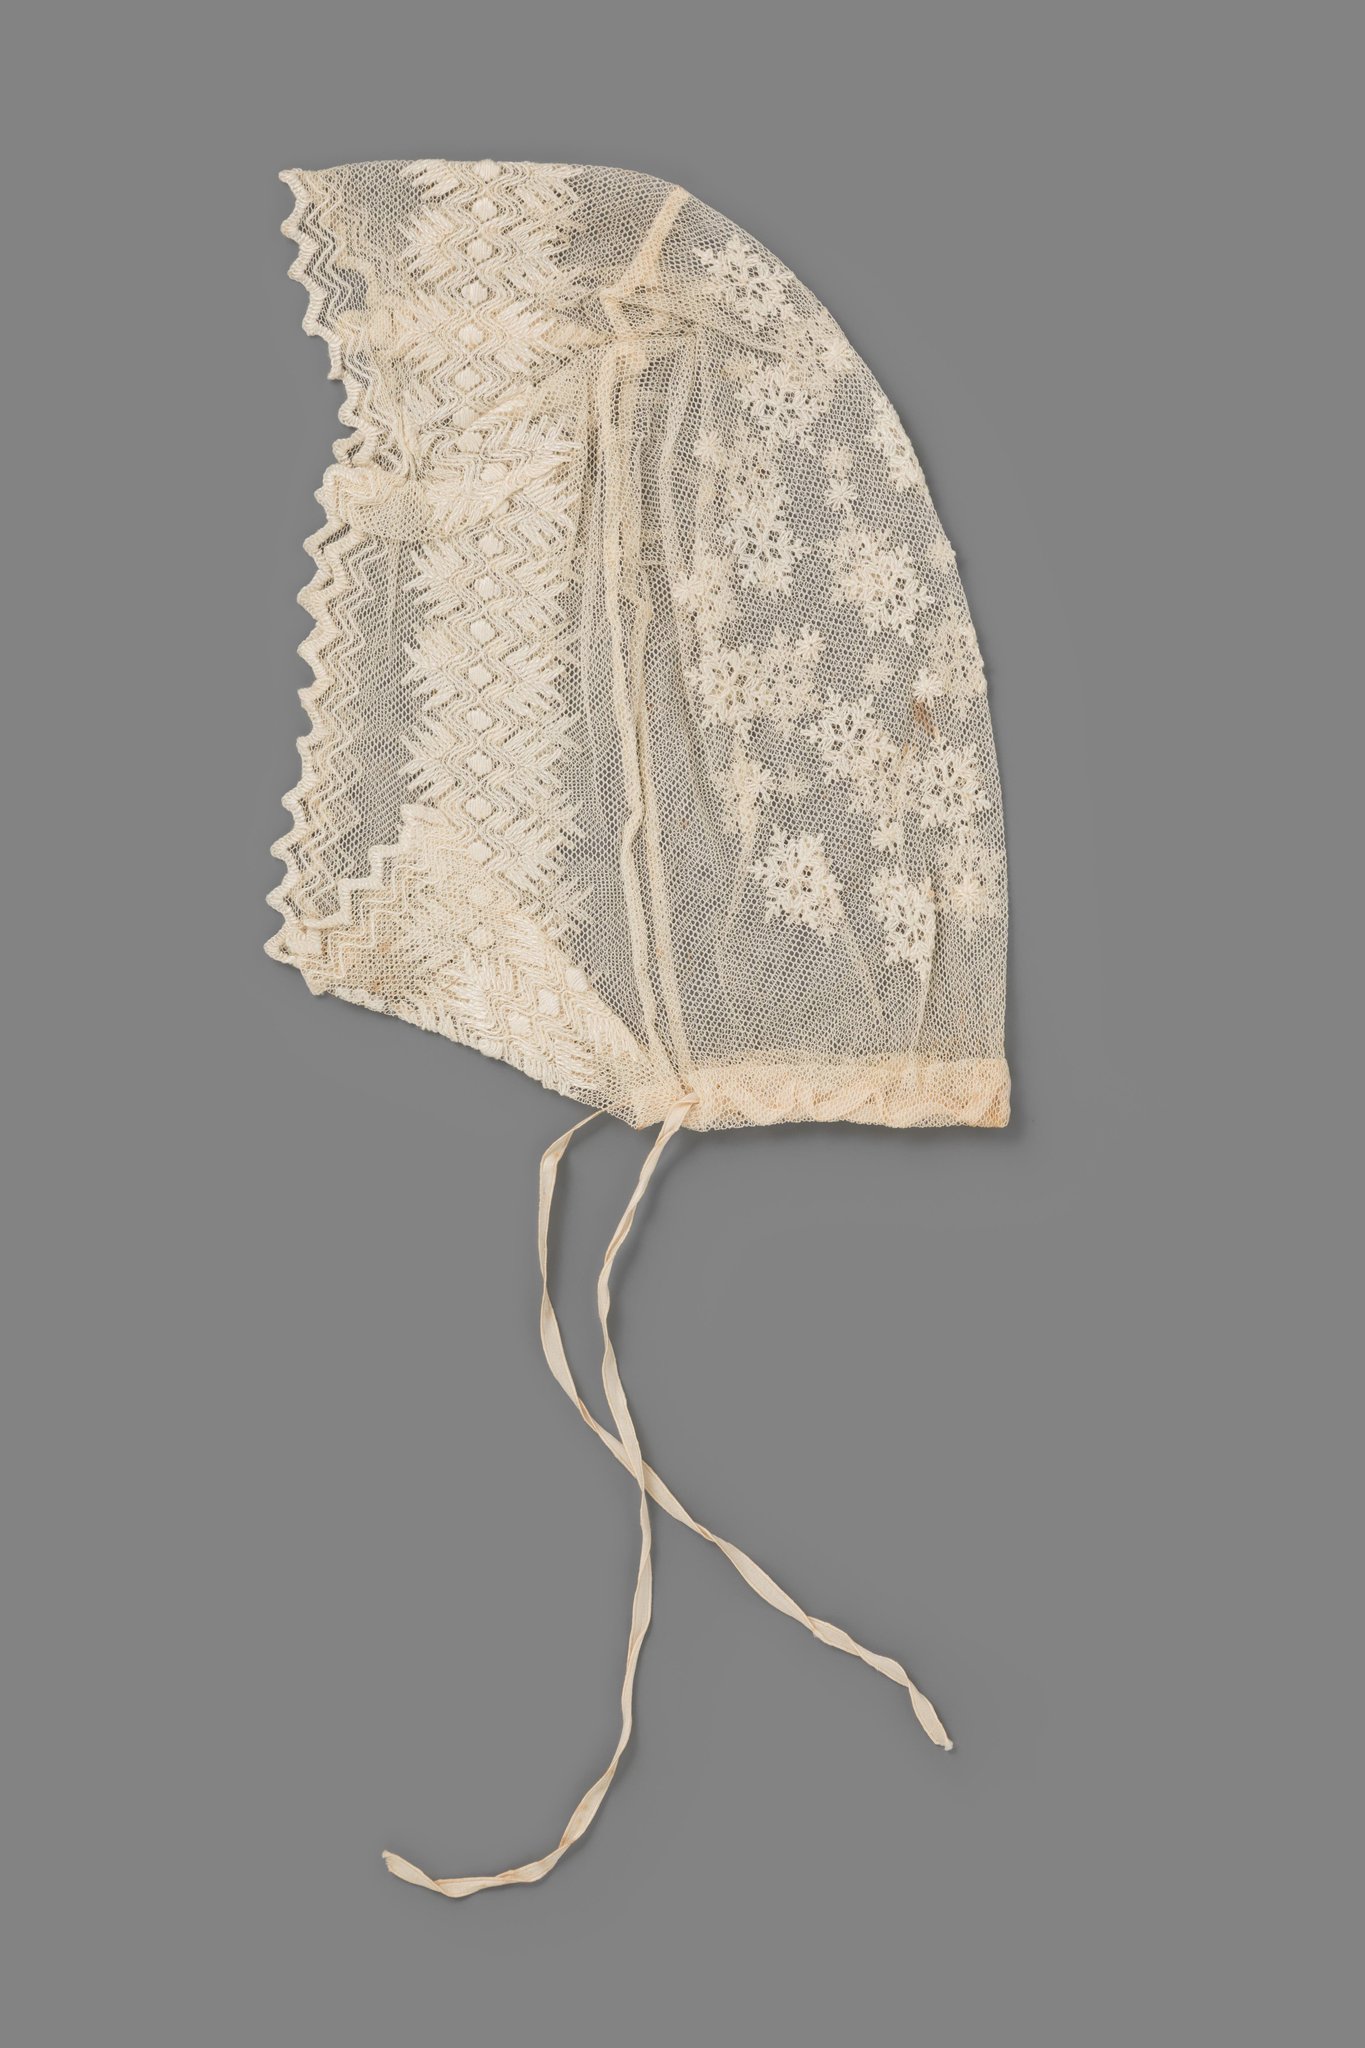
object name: womenswear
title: Muts van tule doorstop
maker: Anonymous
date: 1900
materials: fiber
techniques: stopwork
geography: netherlands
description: Muts van tule doorstop. Het patroon heeft op de mutsenbol gestrooide "sneeuwkristallen", op de rand een dubbele zigzag. De muts kan worden dichtgeregen door middel van een rijgkoord. Bij de muts hoort een vest met invnr. BK-1967-108-B.